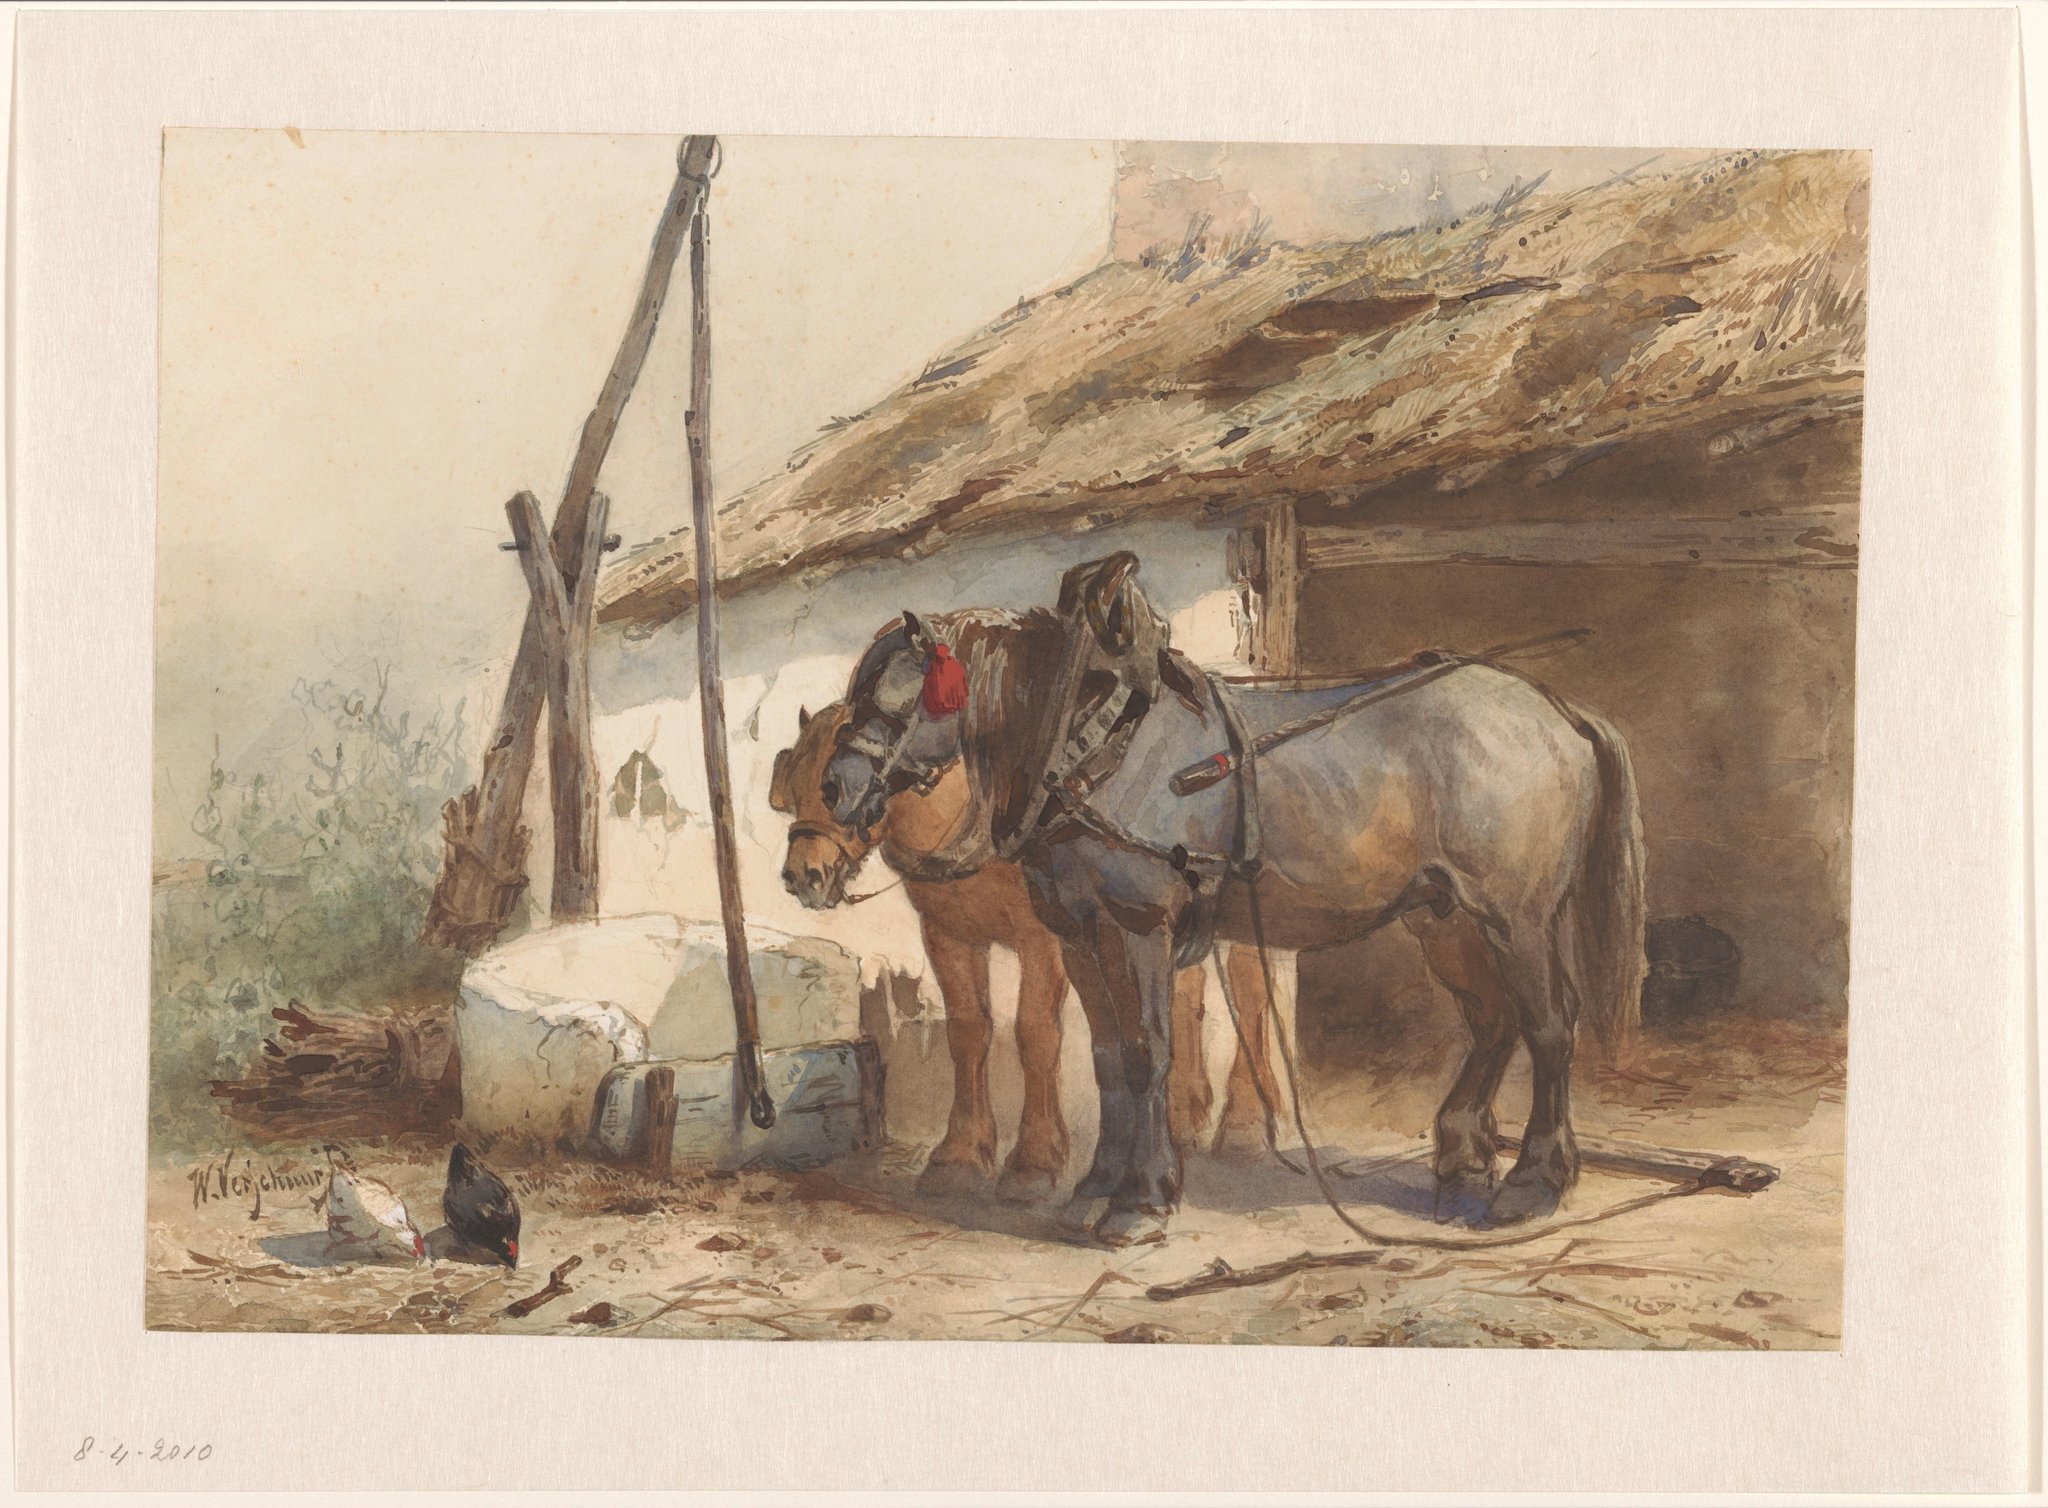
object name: drawing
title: Twee paarden staand voor een stal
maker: wouter verschuur (1841-1936)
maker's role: draughtsman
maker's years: 1841-1936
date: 1851-1921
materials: paper, pencil, watercolor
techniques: brush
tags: horse, stall, stable